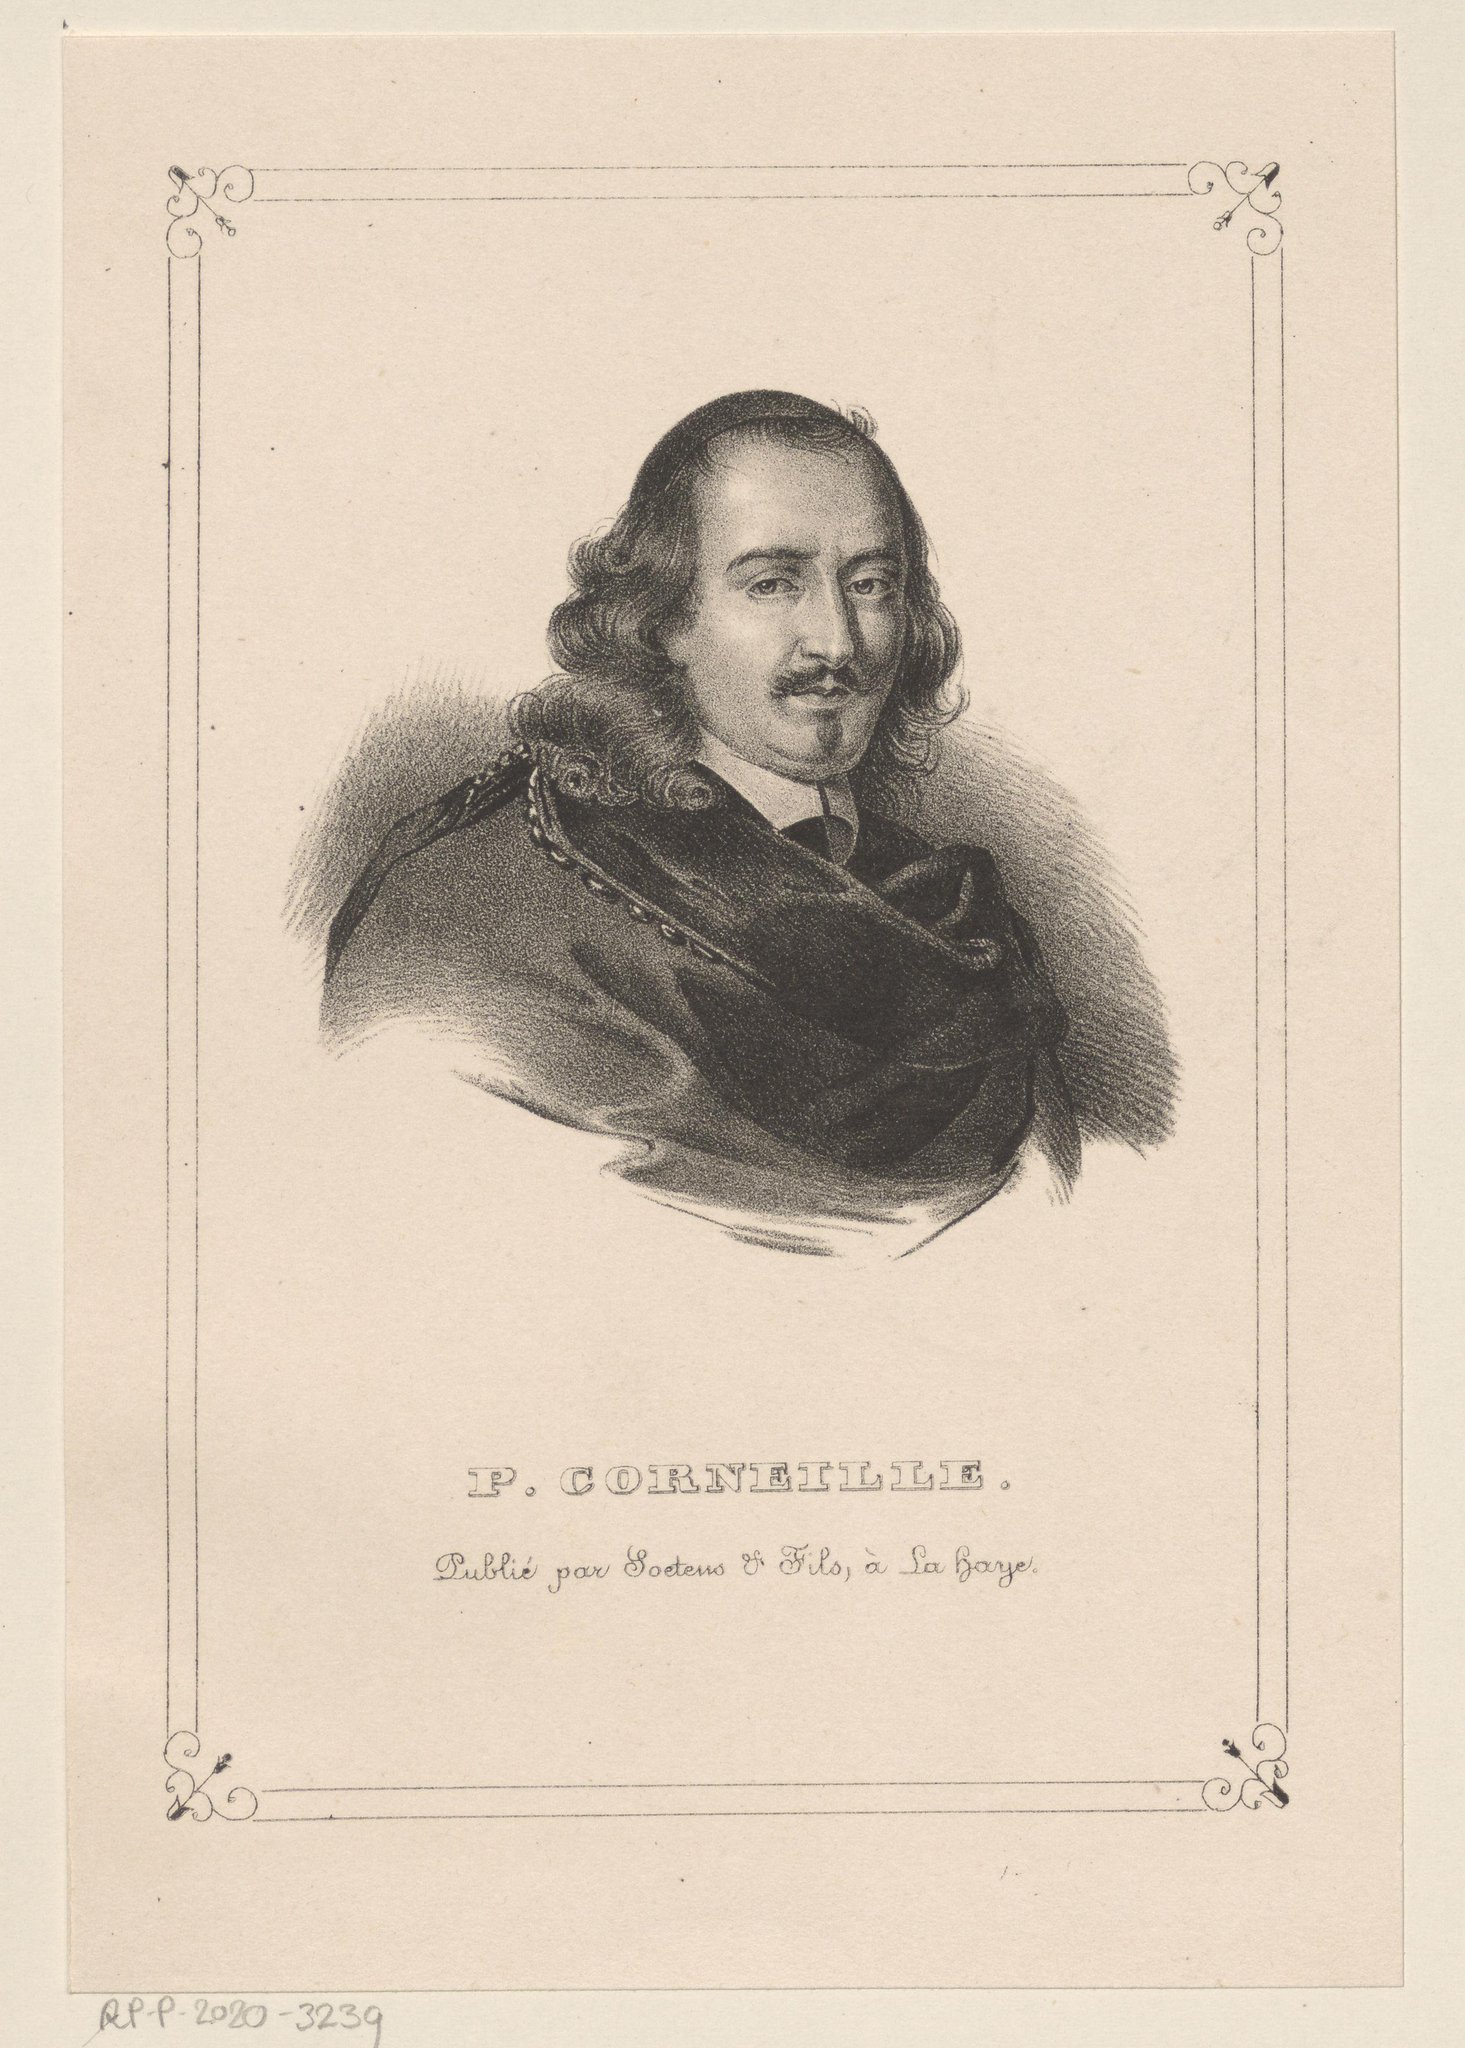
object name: print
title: Portret van Pierre Corneille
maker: Anonymous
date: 1837-1840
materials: paper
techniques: lithograph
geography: the hague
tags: pierre corneille, historical persons